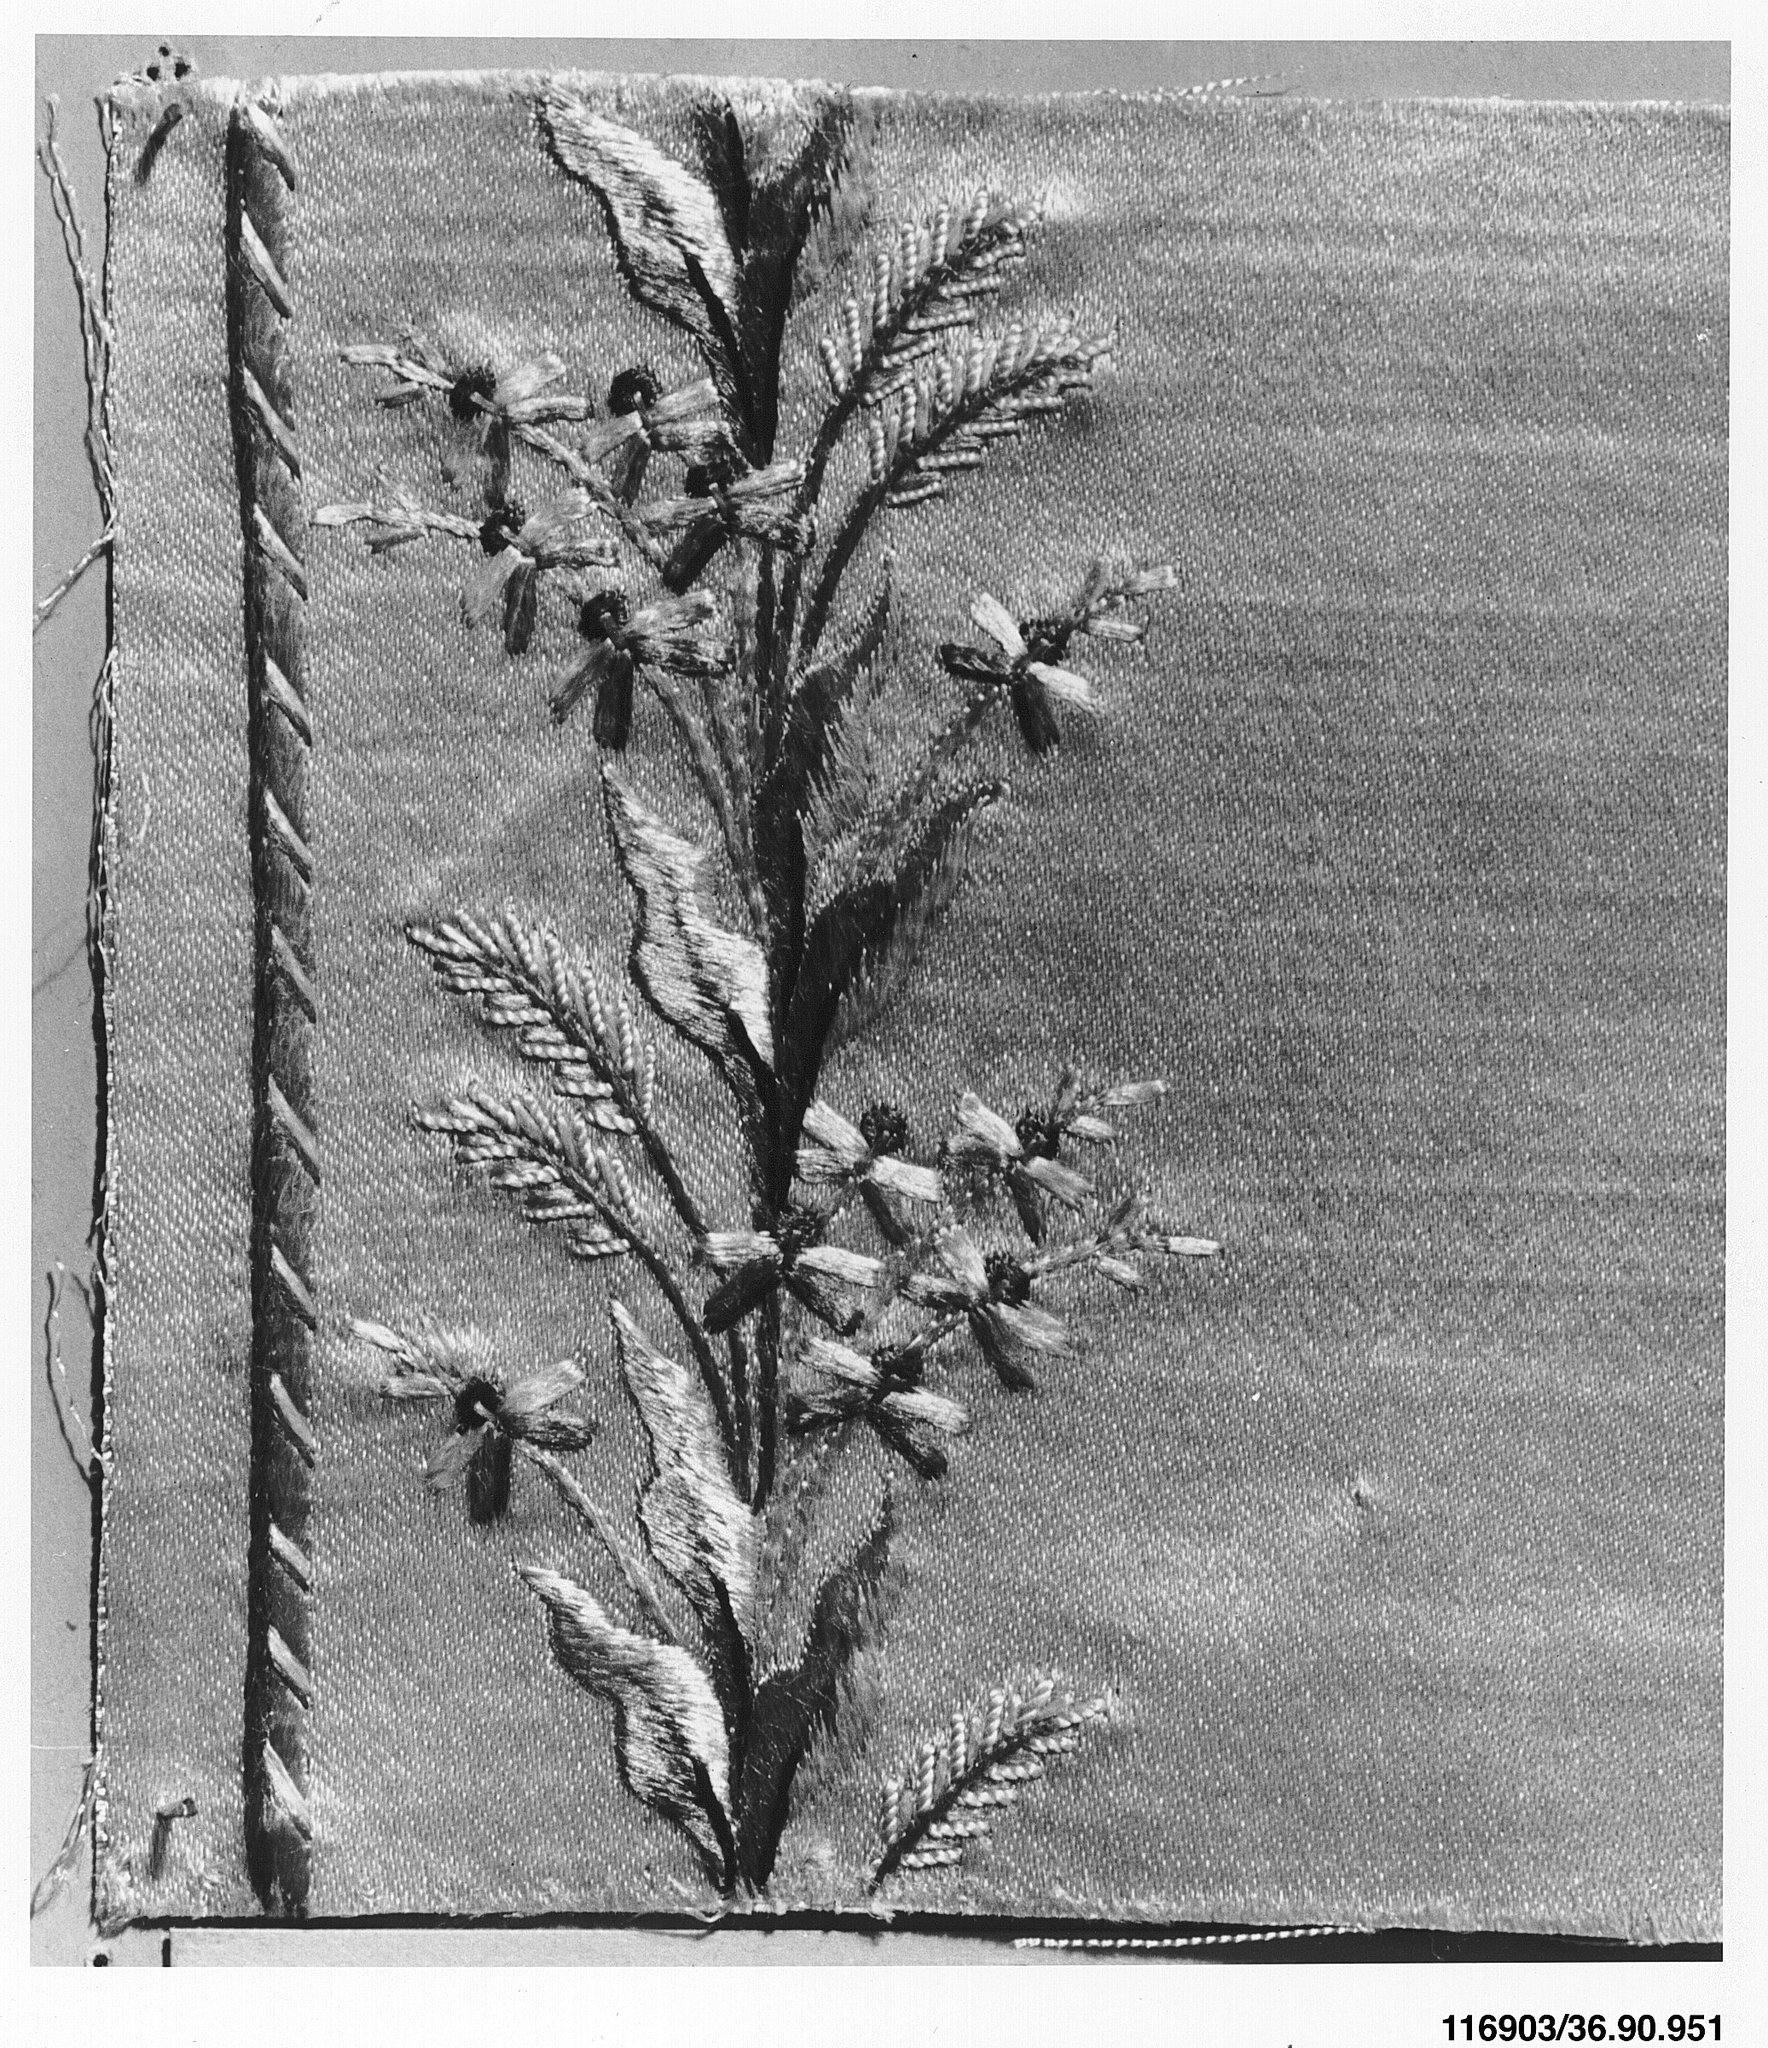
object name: sample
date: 1801-1833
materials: silk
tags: plants